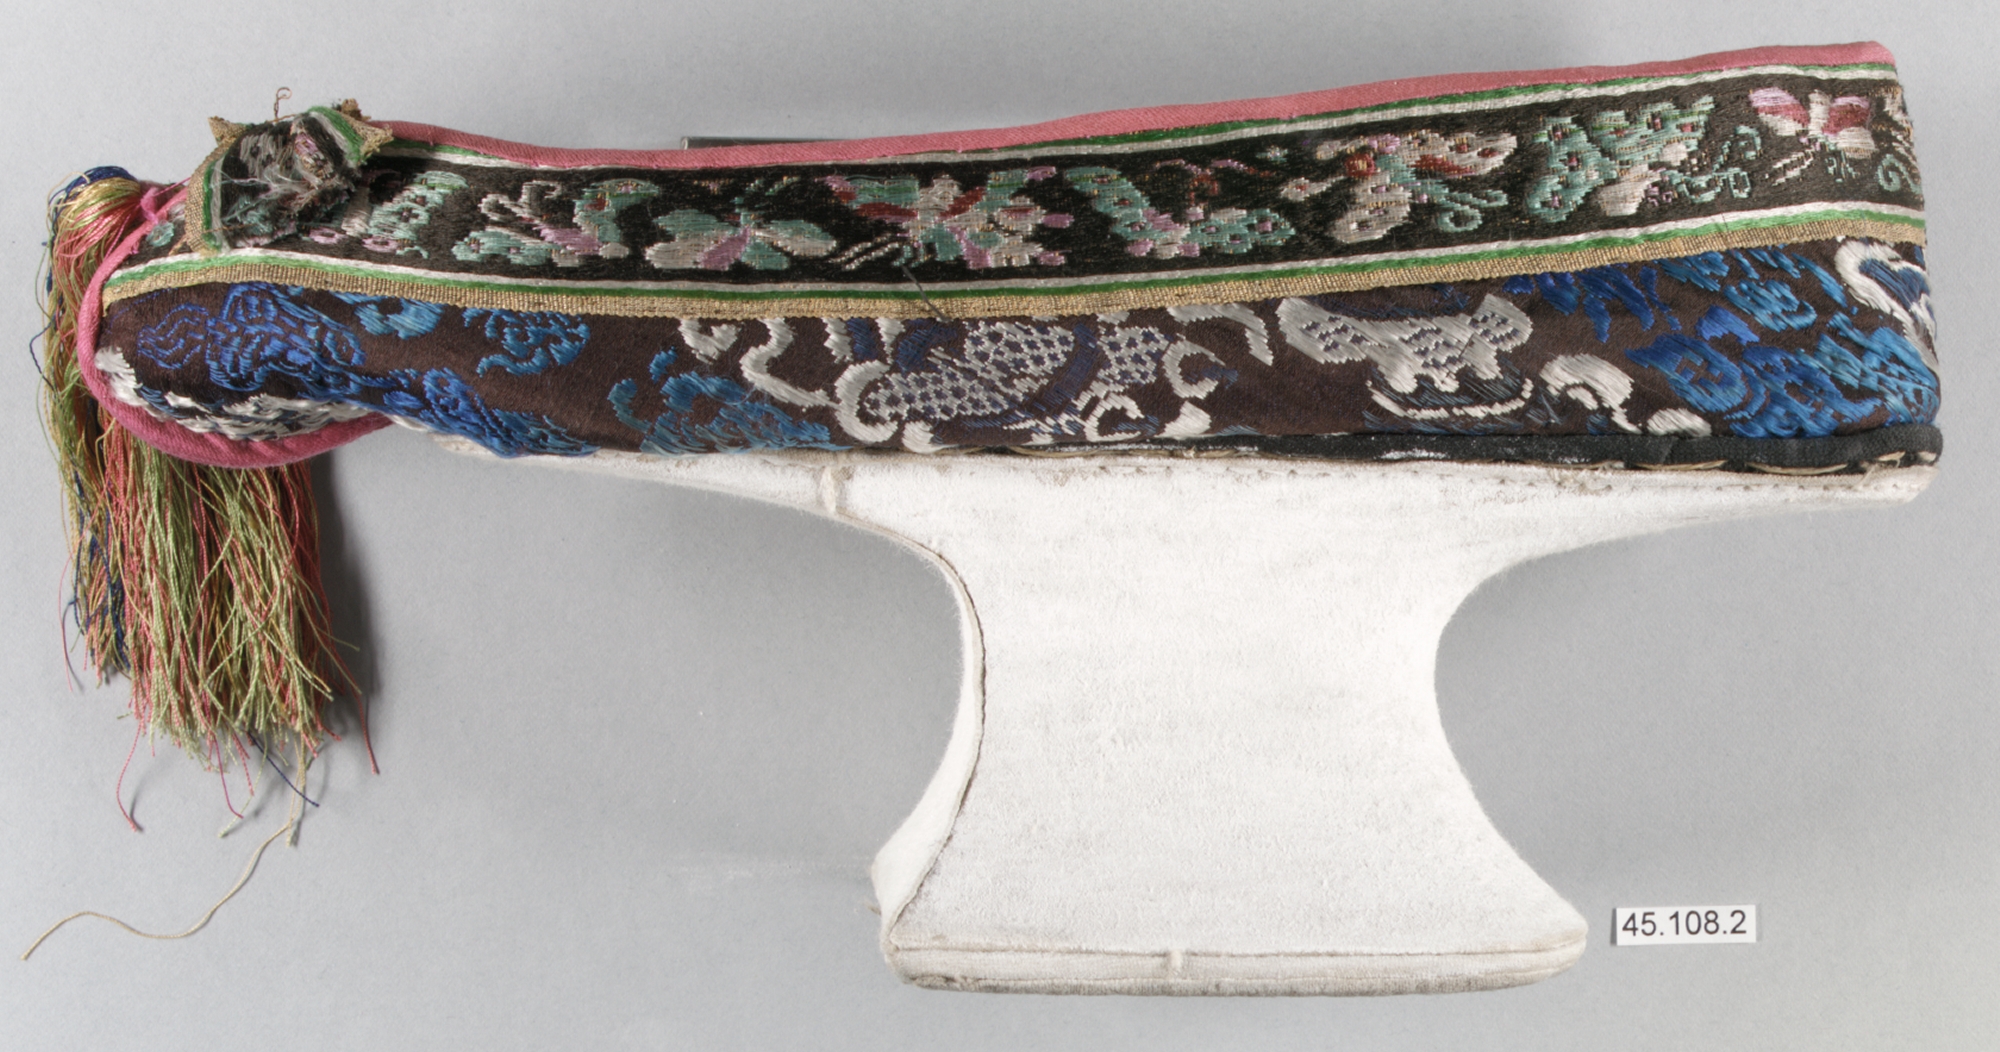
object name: manchu woman's shoe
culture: chinese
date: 1867-1933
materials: silk, wood